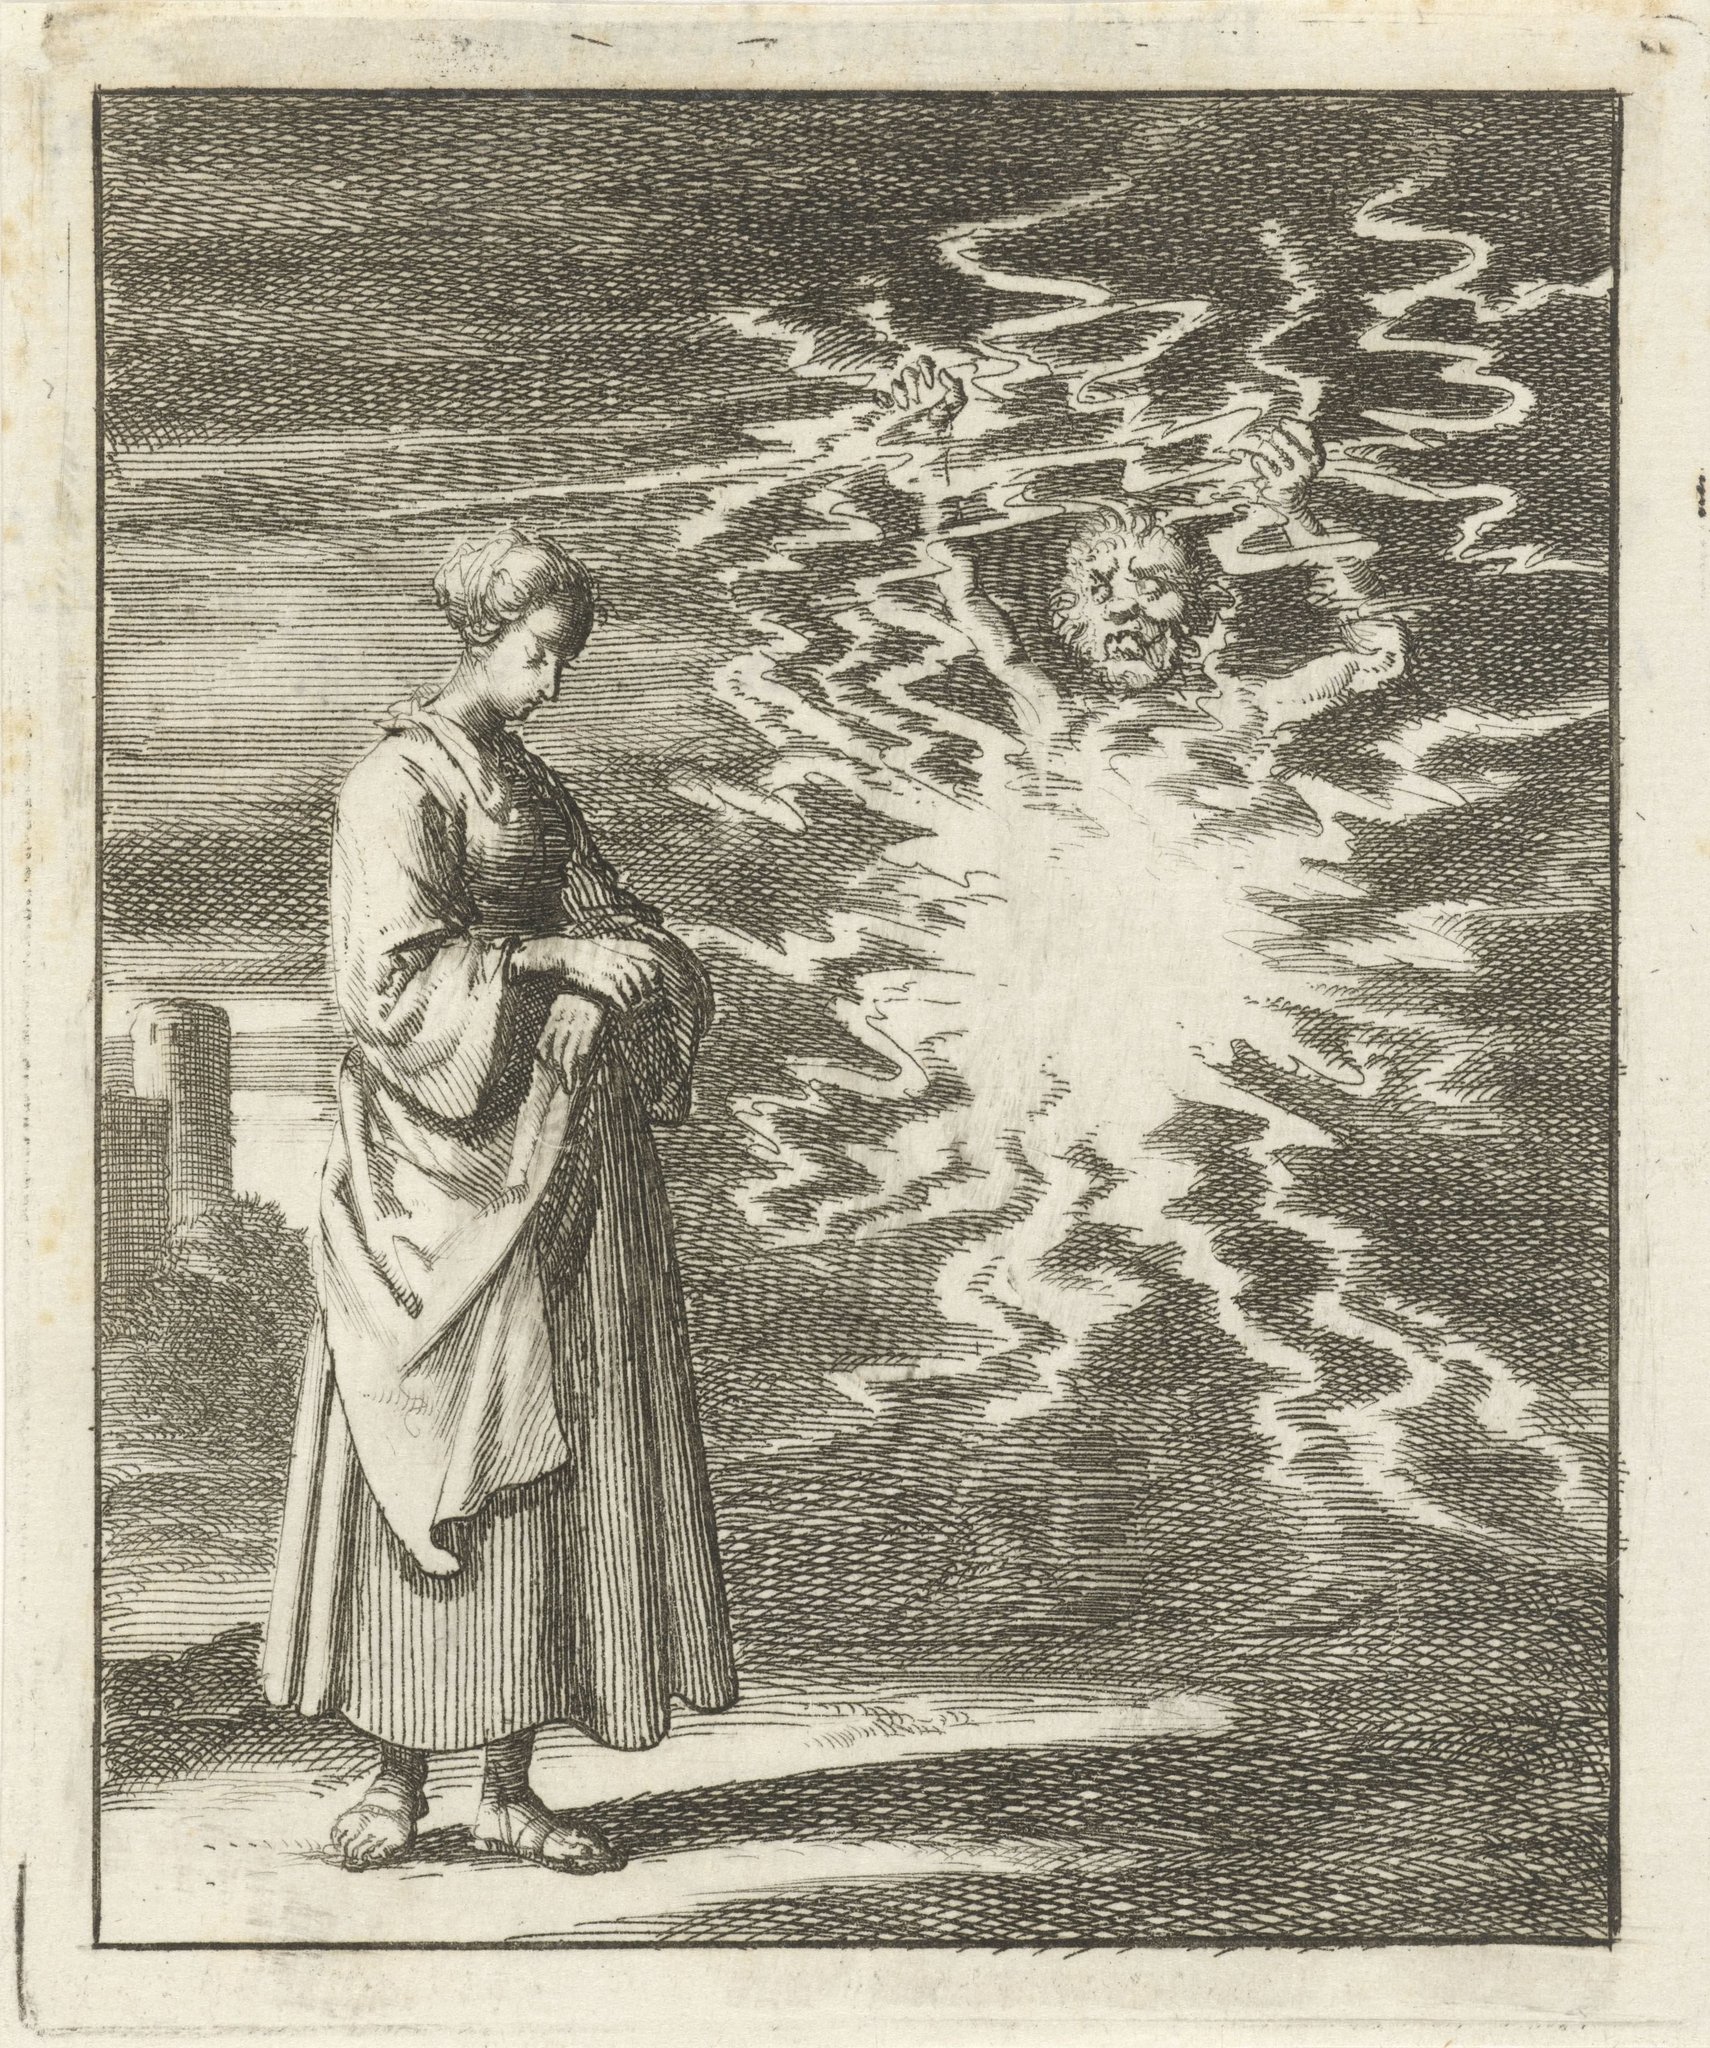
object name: book illustration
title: Vrouw wandelt rustig langs de in vlammen gehulde Satan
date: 1687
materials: paper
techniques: etching, letterpress printing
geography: amsterdam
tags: devil(s) and demons: satan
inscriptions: collector's mark: Lugt 2228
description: Illustratie uit: Luyken, Jan. Voncken der liefde Jesu, van het godtbegerende zielenvier. Amsterdam: Pieter Arentsz (II), 1687, p. 152.